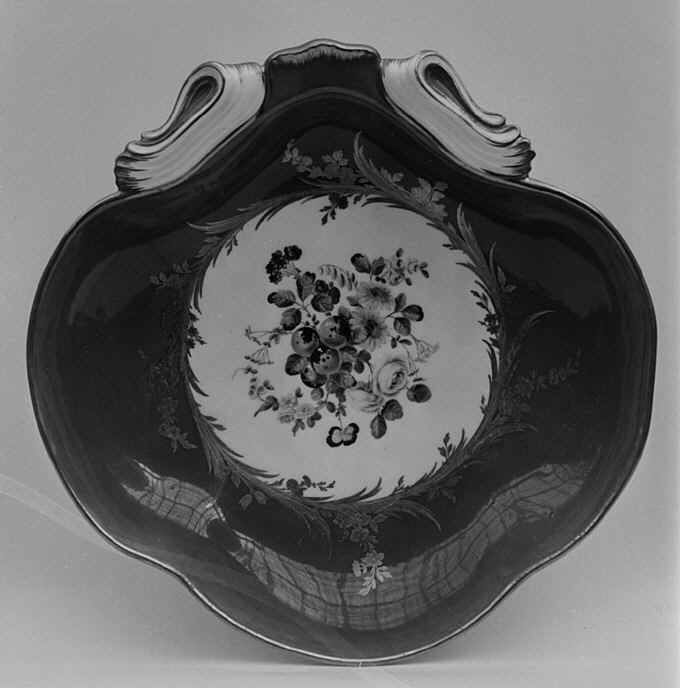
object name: fruit dish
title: Fruit dish (part of a service)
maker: sèvres manufactory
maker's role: manufactory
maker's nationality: french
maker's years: 1740-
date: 1771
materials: hard paste porcelain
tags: flowers